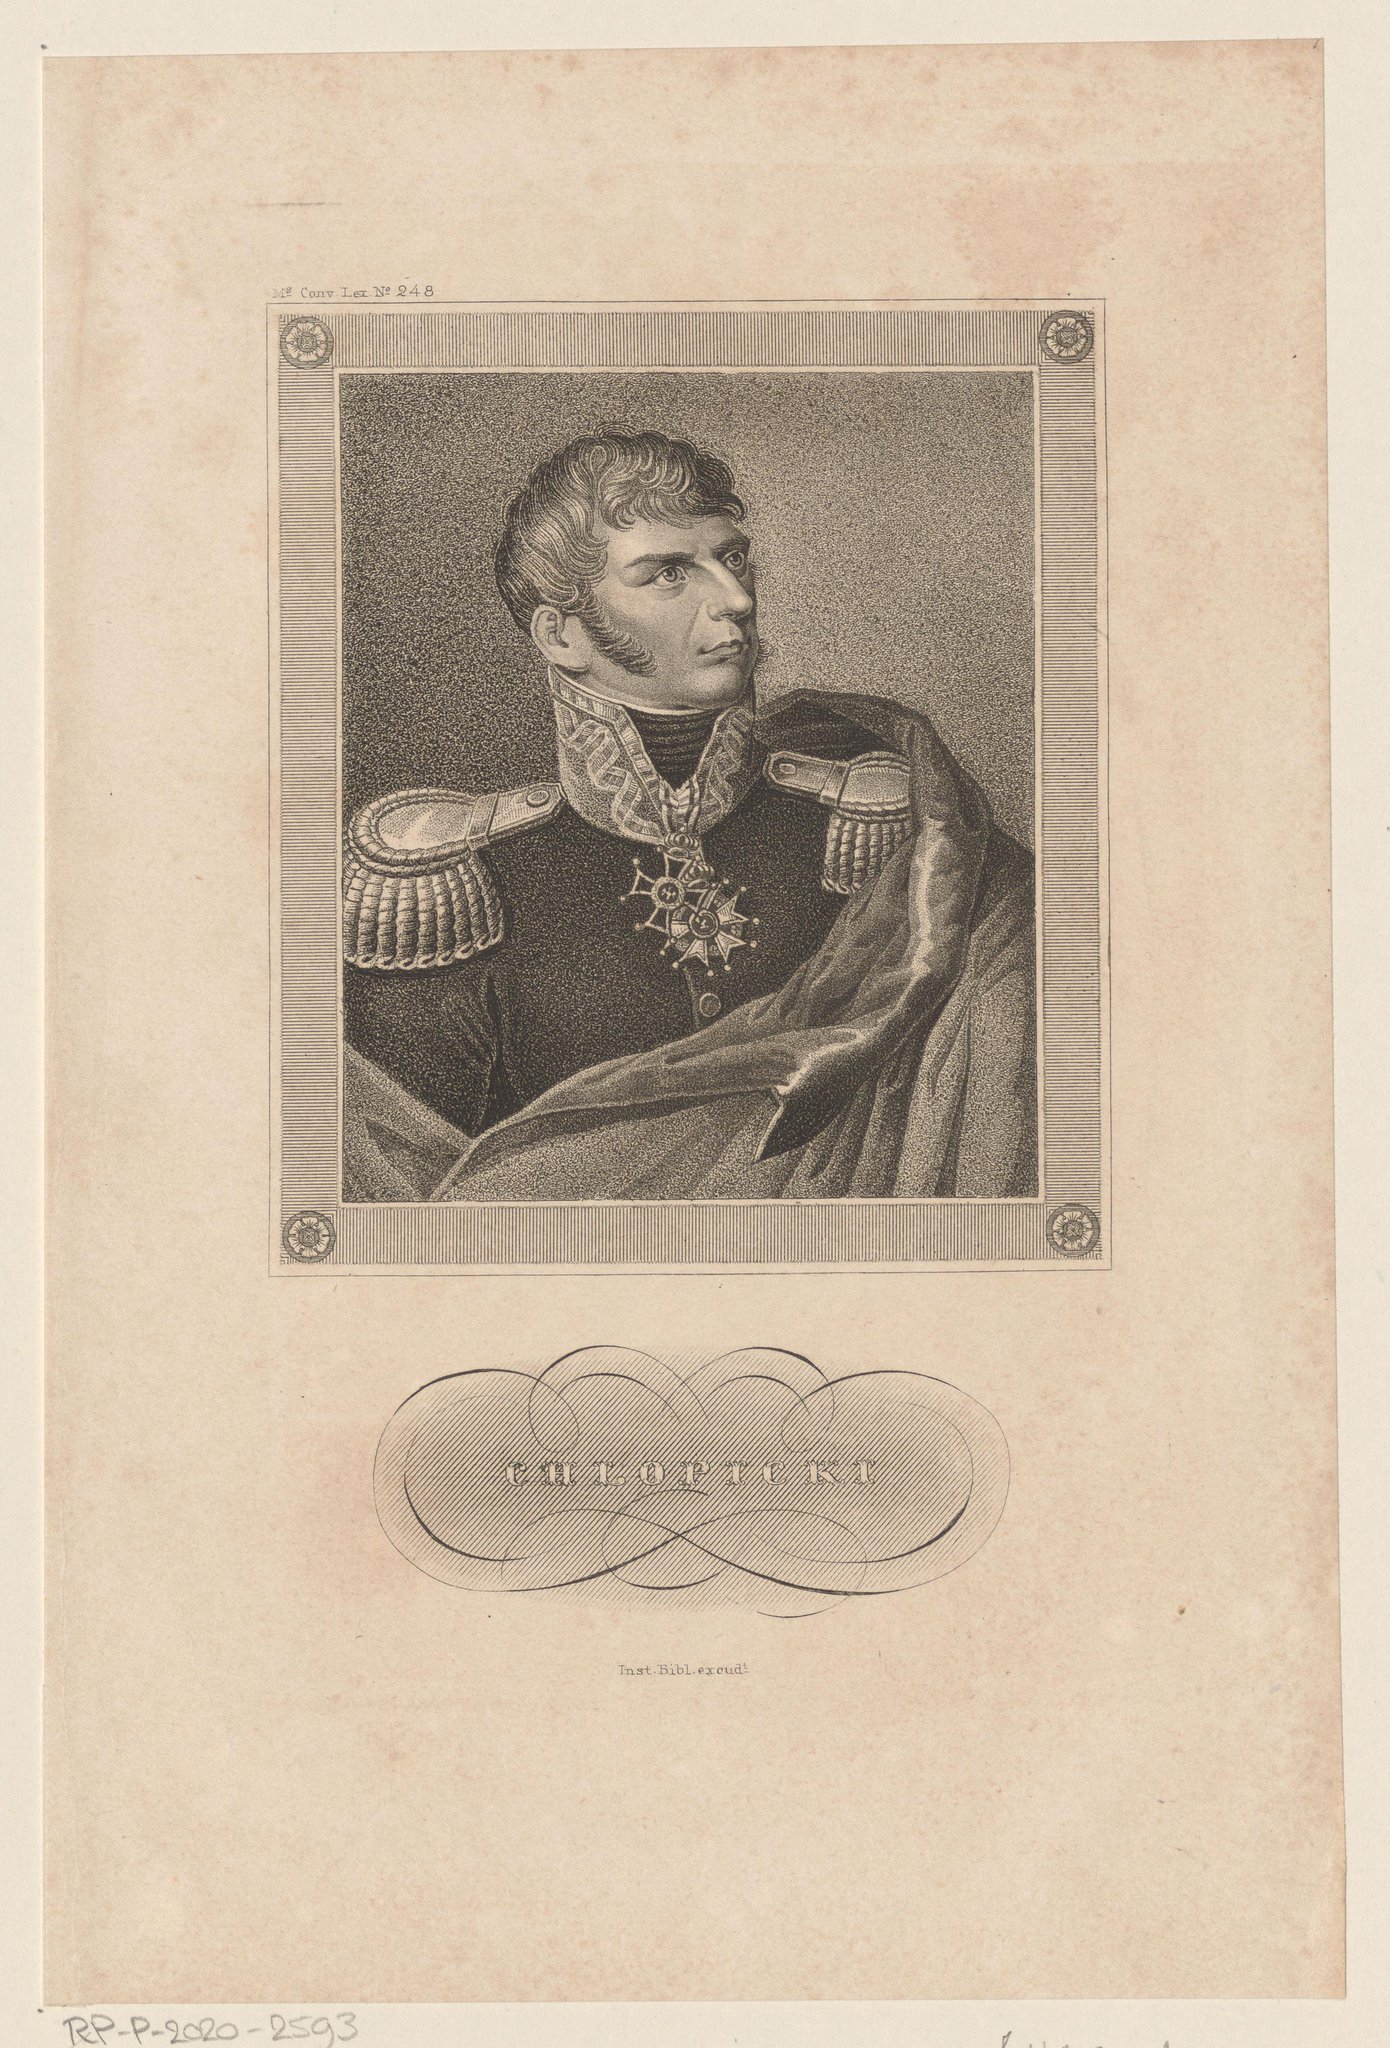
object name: print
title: Portret van Józef Chłopicki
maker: Anonymous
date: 1839-1855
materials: paper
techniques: etching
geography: hildburghausen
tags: historical persons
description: Prent uit: Meyer, Joseph. Conversations-Lexikon für die gebildeten Stände. Hildburghausen: Bibliographisches Institut, 1839-1855.